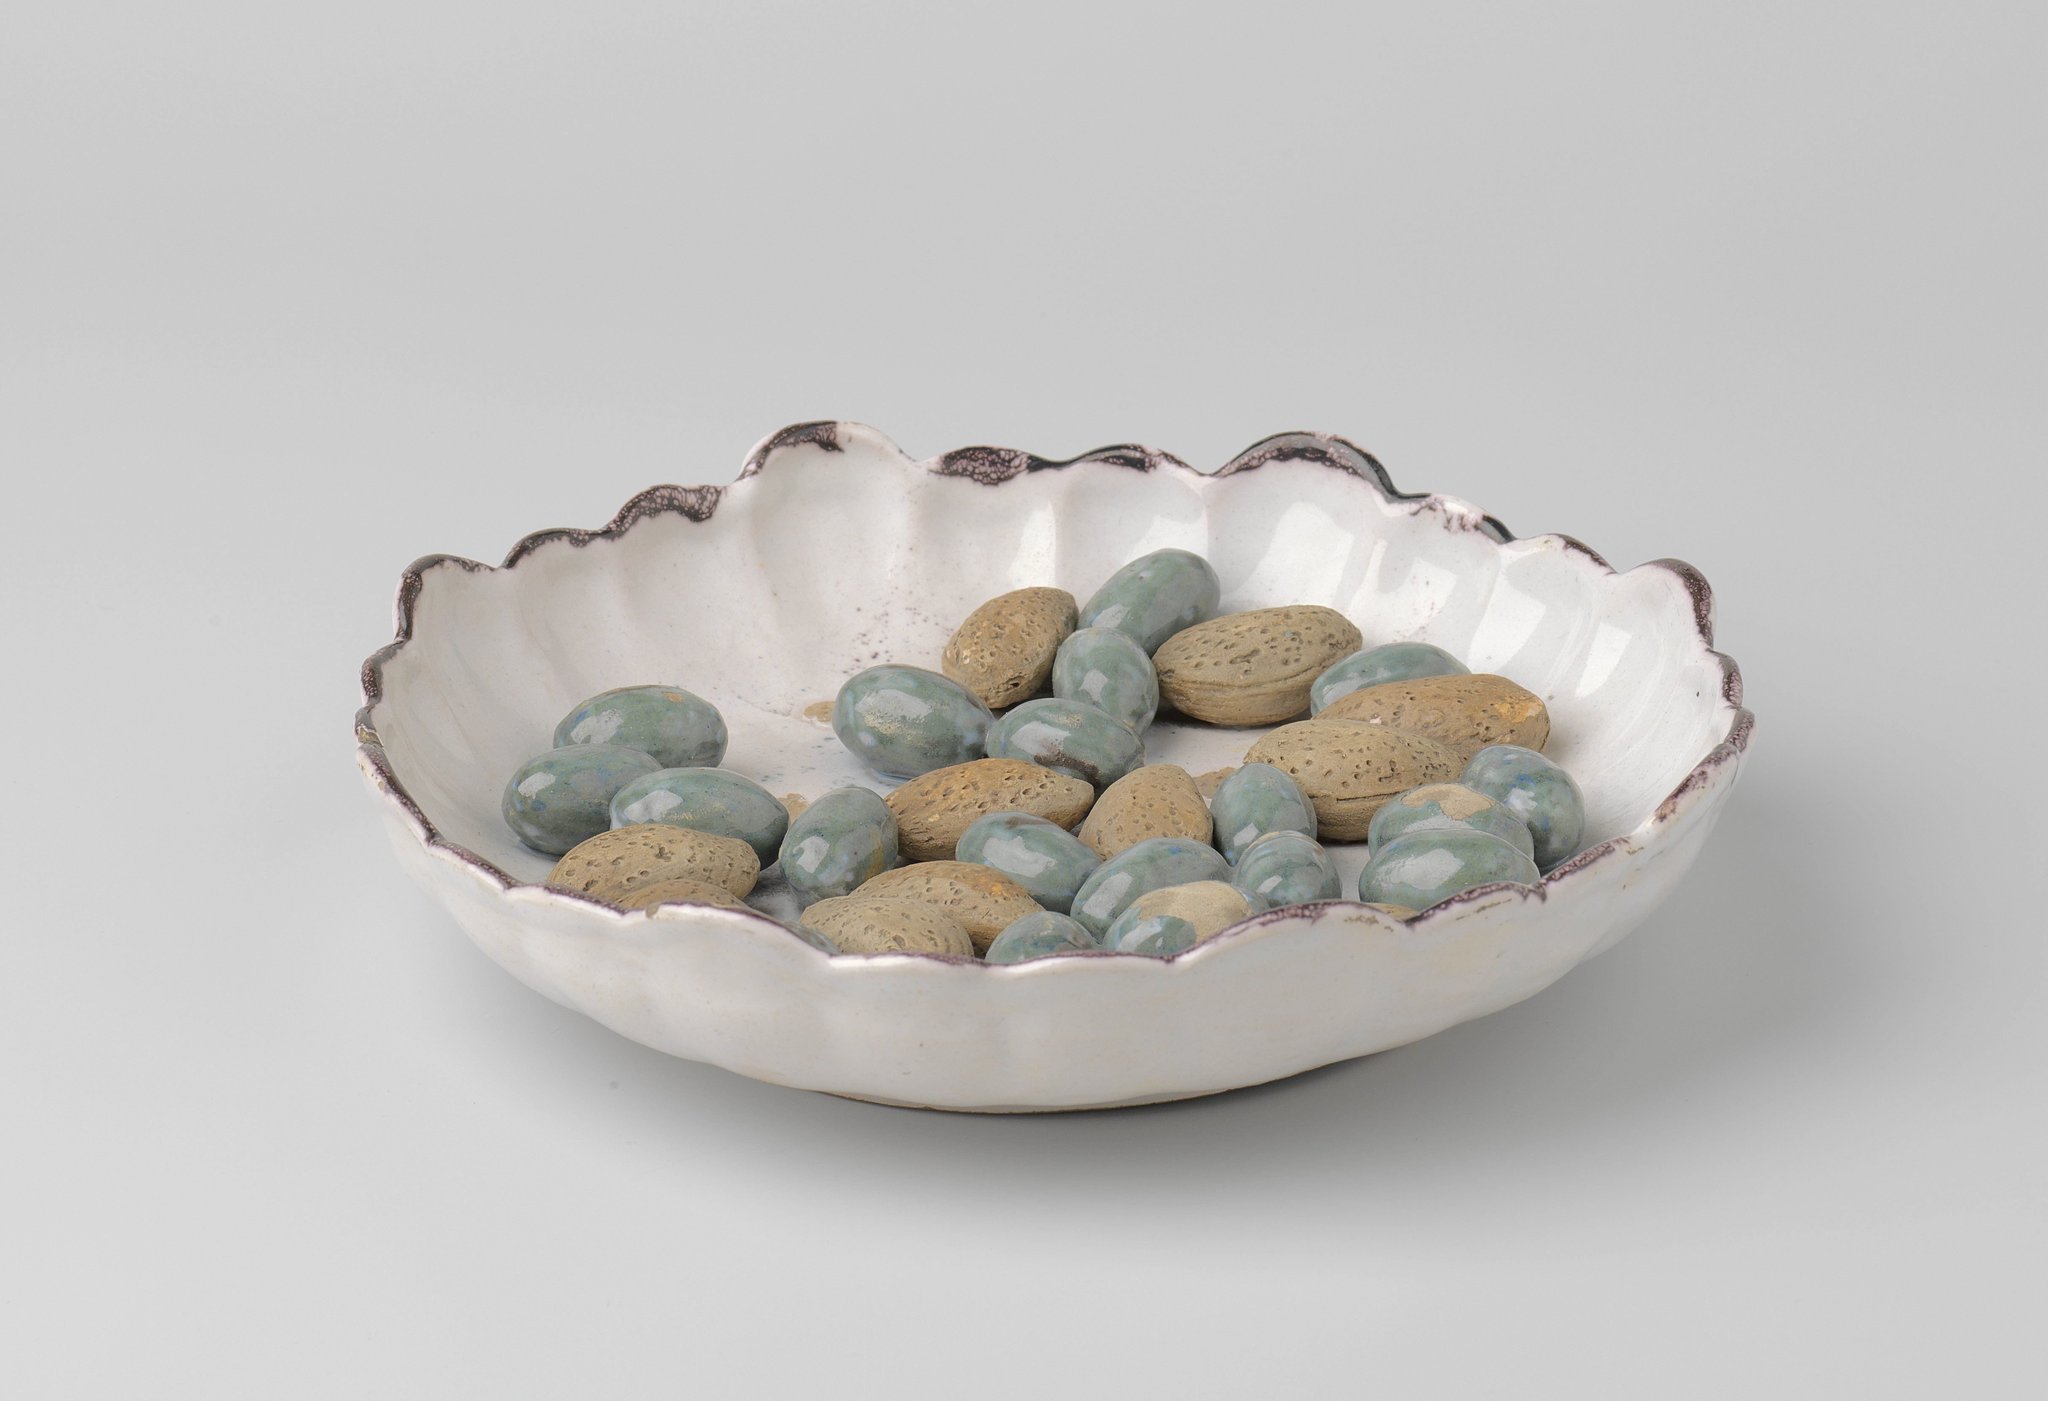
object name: decoratief object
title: Schotel met geschulpte rand en met opgelegde olijven en amandelen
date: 1755-1760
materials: earthenware, glaze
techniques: painted, polychromy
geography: amsterdam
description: Ronde, witte schotel met olijven en amandelen van veelkleurig beschilderde faience. De schotel heeft een geschulpte rand en op de schotel zijn amandelen en olijven bevestigd, waarvan er vier ontbreken.